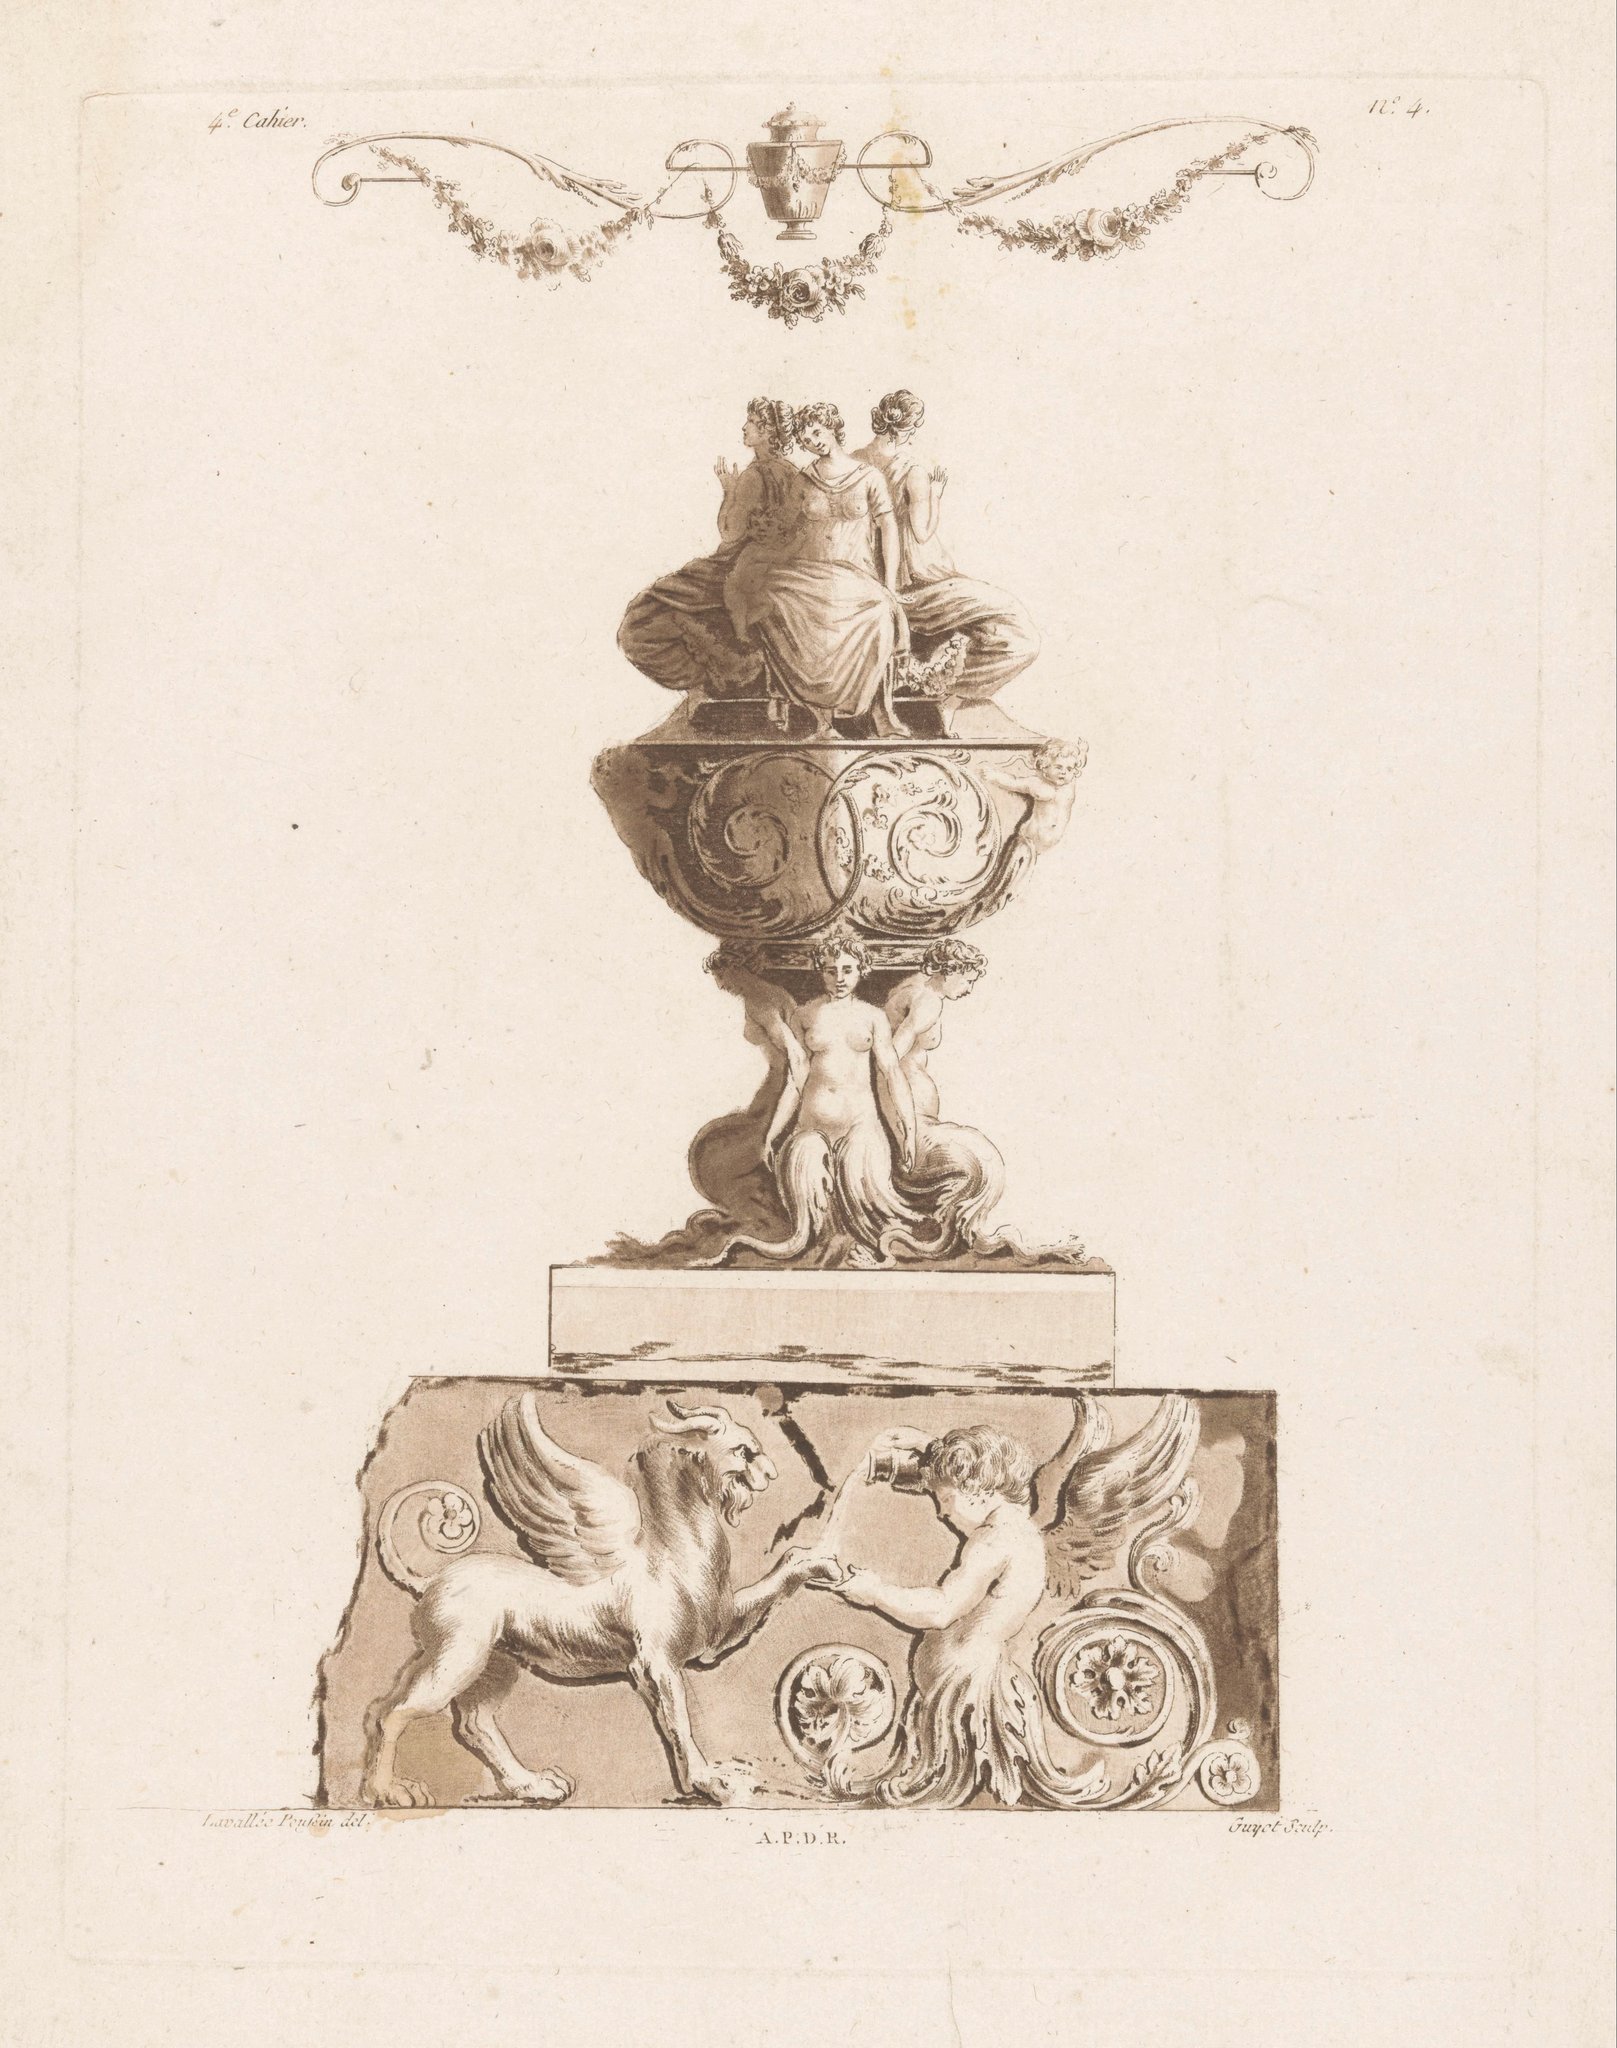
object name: ornament print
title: Vaas met vrouwen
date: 1788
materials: paper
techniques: aquatint, etching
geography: rome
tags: sitting figure - aa - female human figure, vase ~ ornament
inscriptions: collector's mark: Lugt 2228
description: Een vaas met drie meerminnen, arabesken en drie zittende vrouwen staat op een voetstuk met een griffioen en een putto als halffiguur. Aan de bovenzijde een vaas, guirlandes en arabesken.